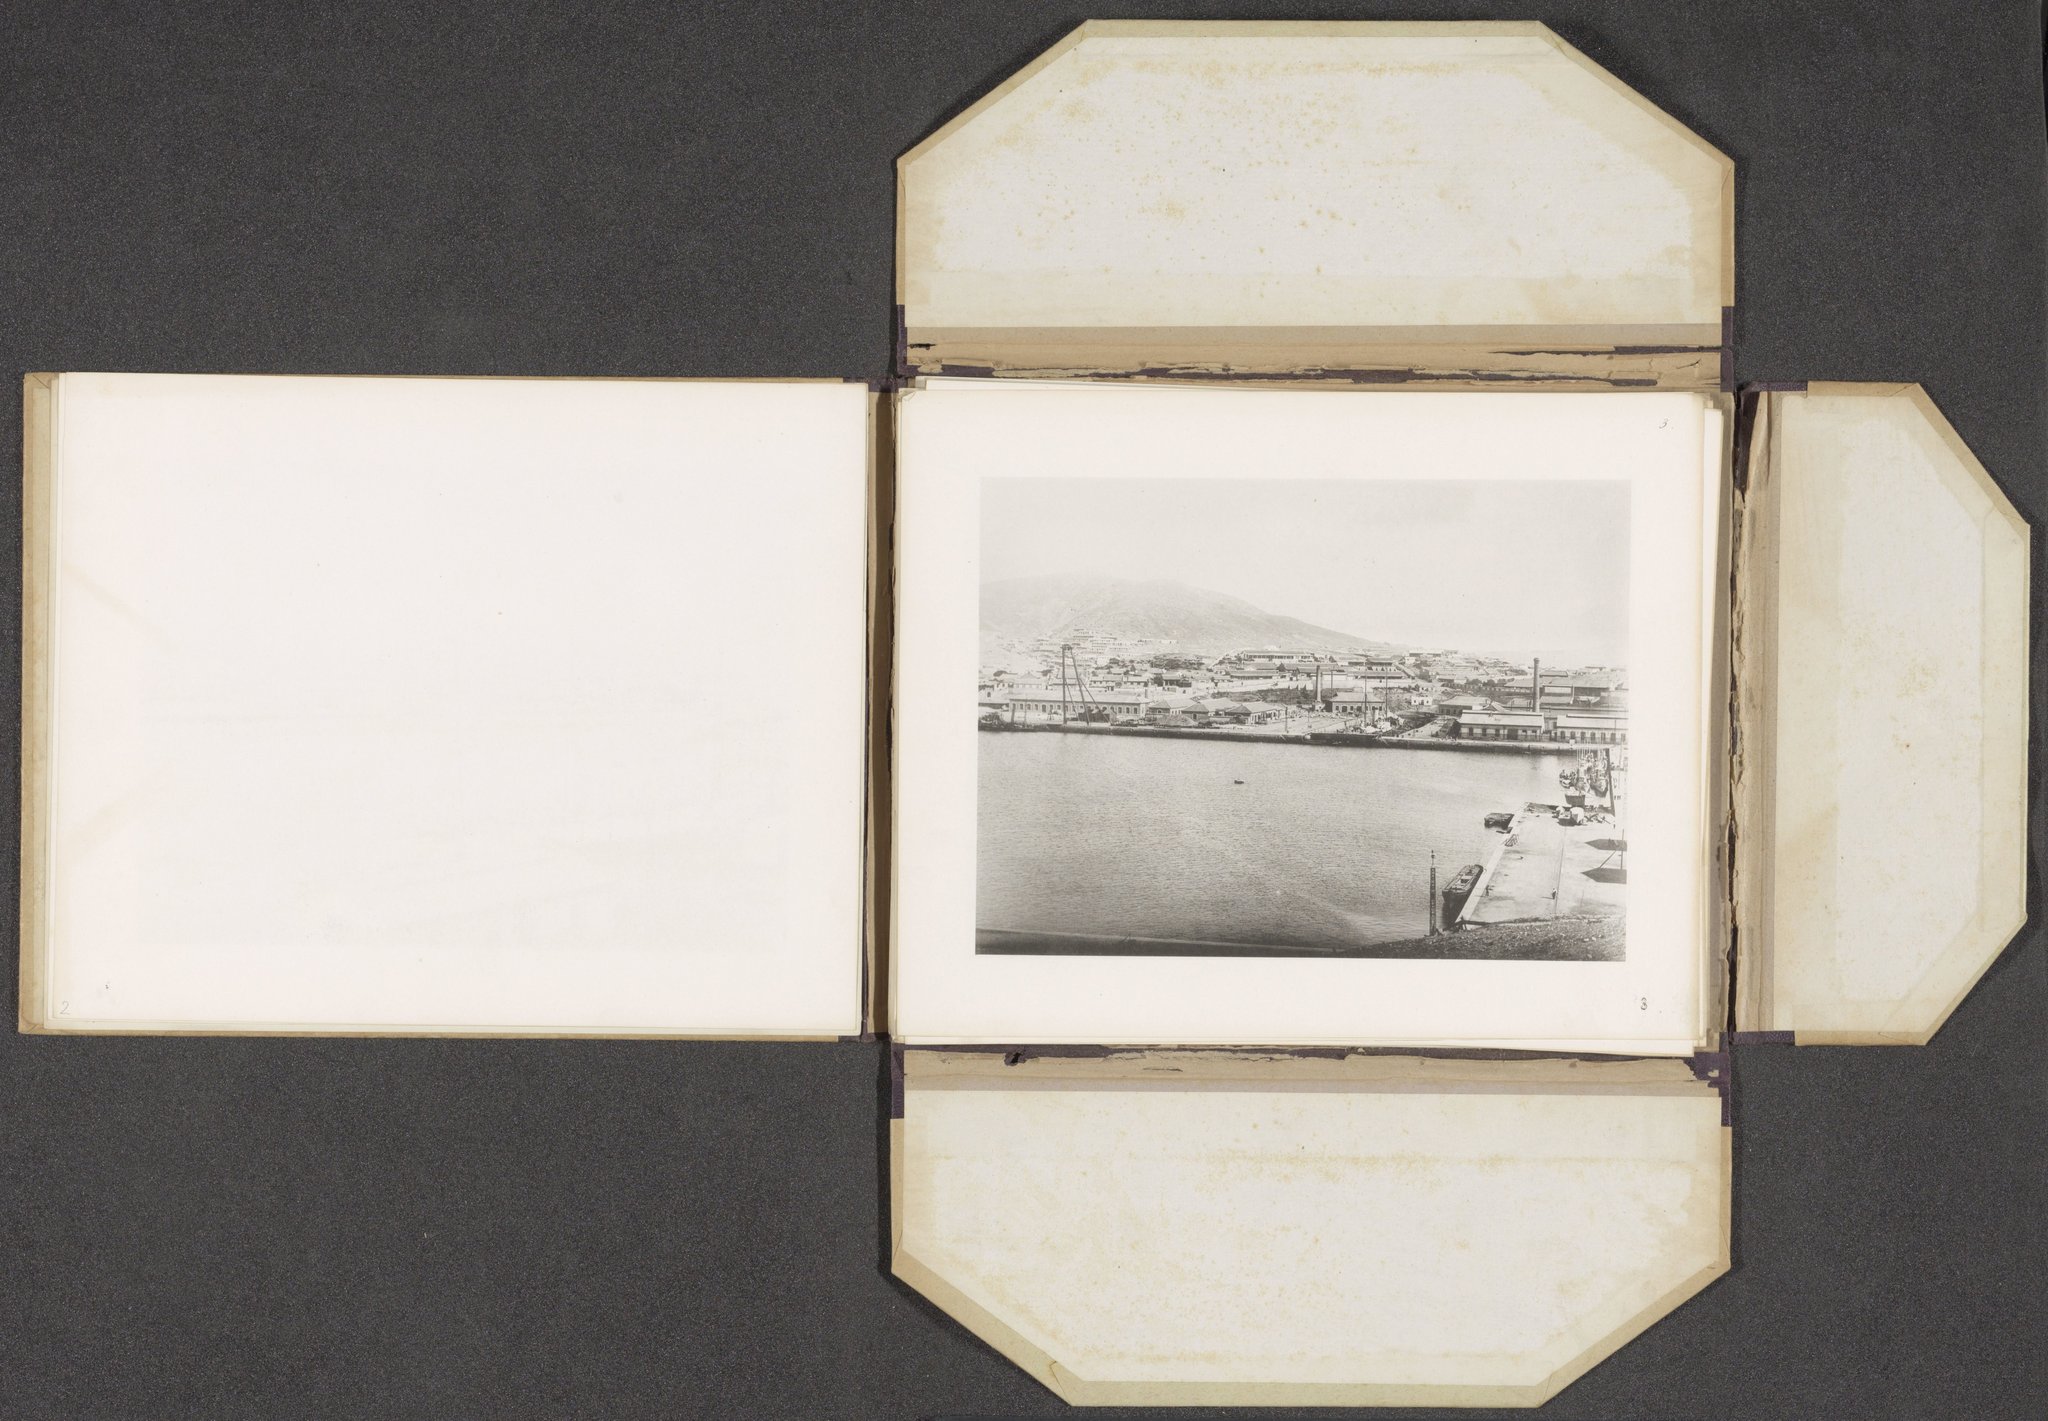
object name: photomechanical print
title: Gezicht op Port Arthur, met op de voorgrond de Gele Zee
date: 1898-1899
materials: paper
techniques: photograph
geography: port arthur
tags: harbour, city-view in general; 'veduta', sea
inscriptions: number: ‘41.-’, number: ‘3’